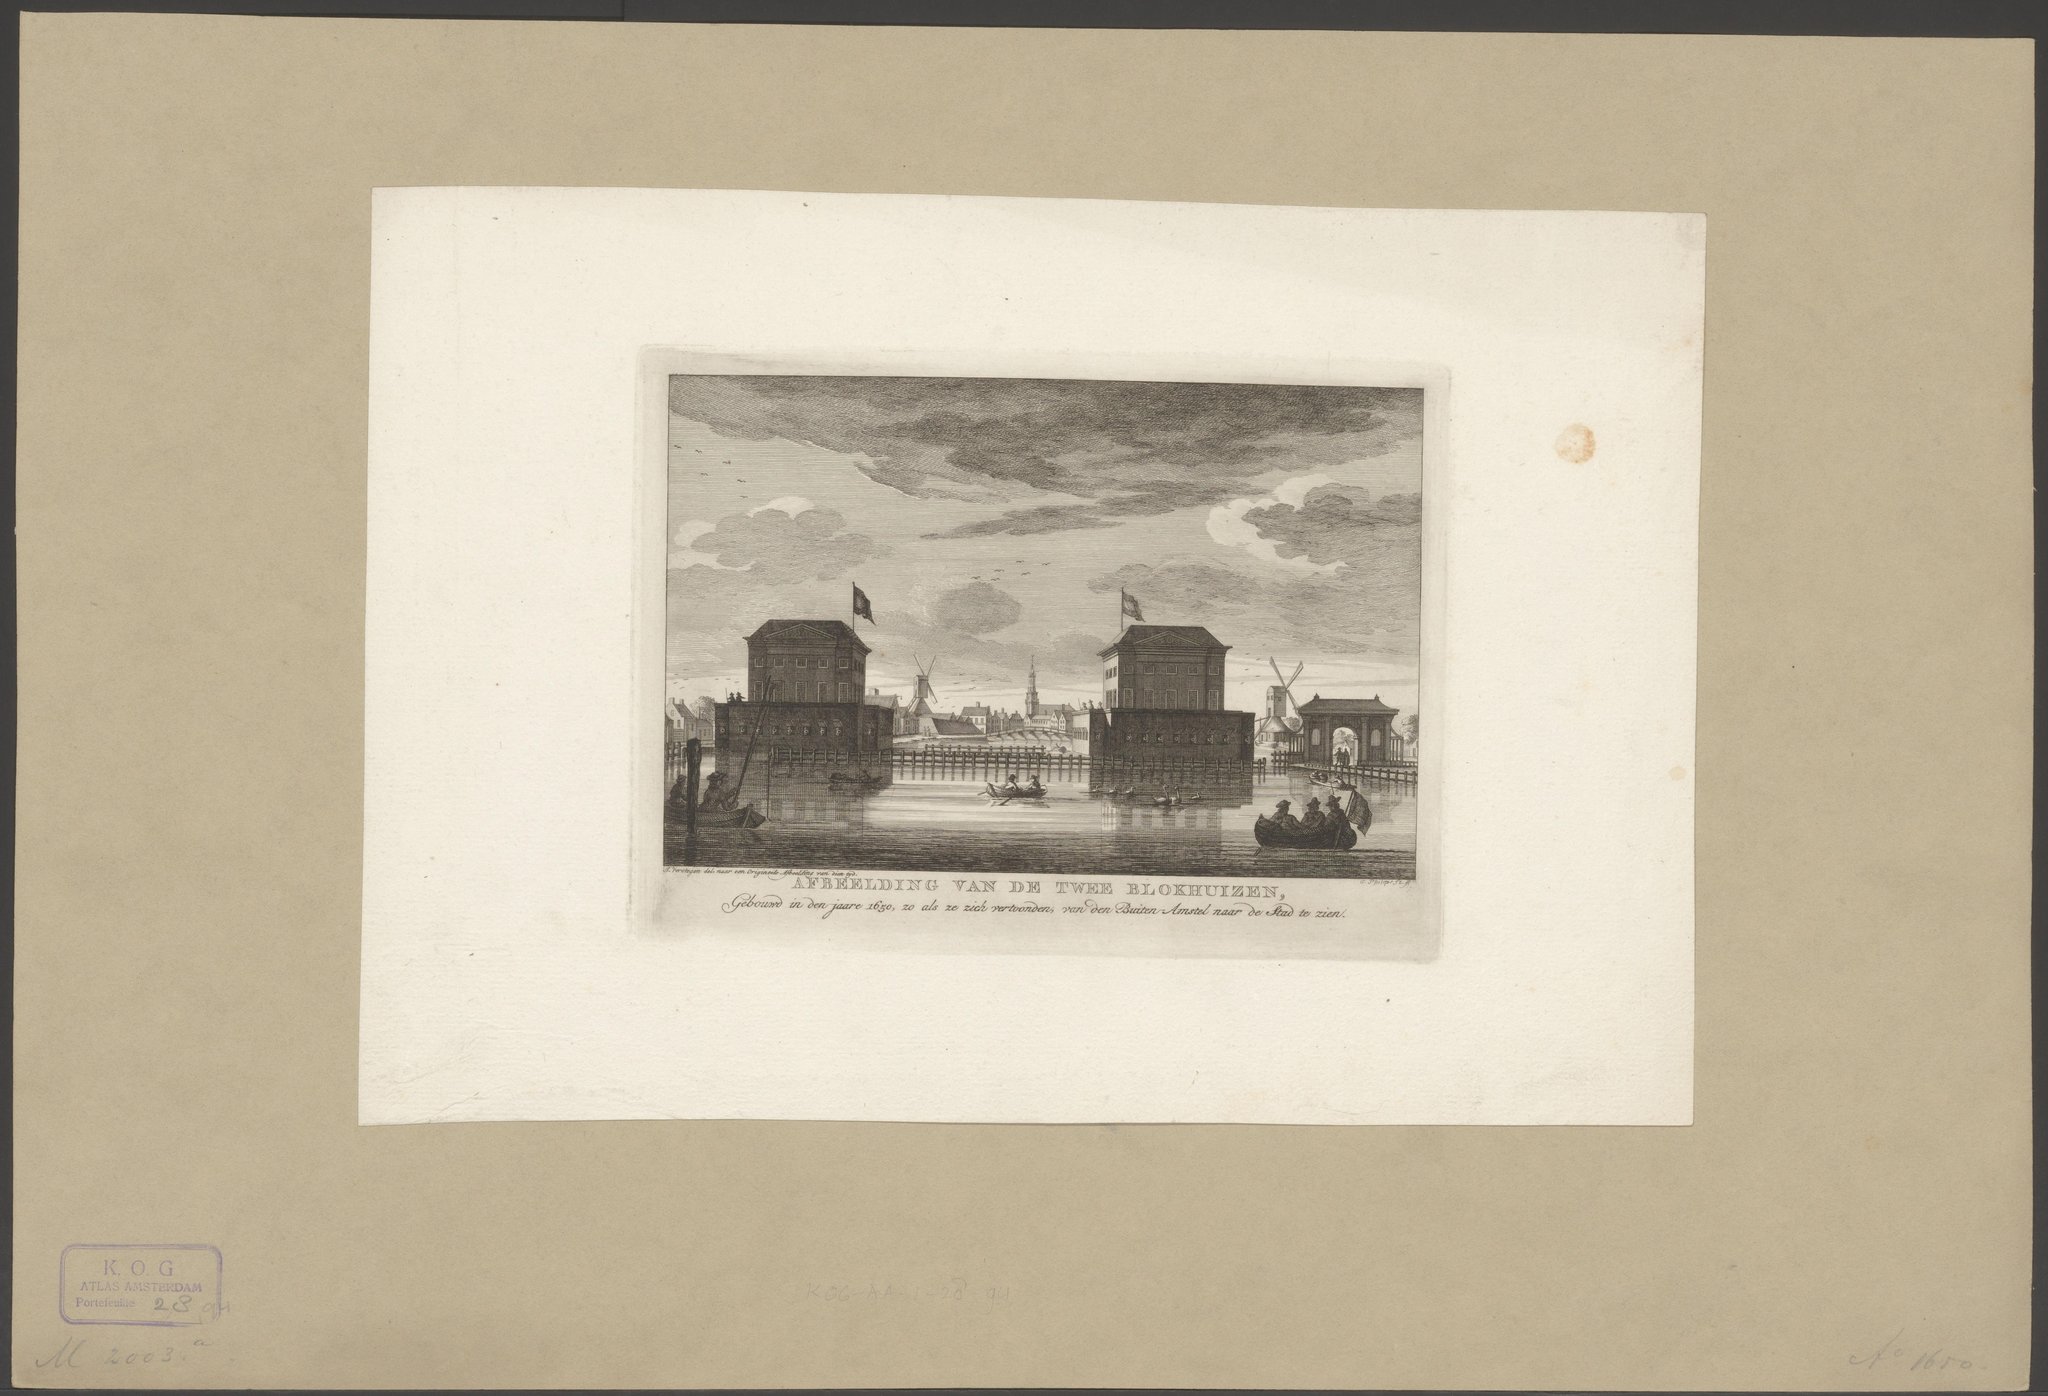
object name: print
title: Gezicht op de twee Blokhuizen in de Amstel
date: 1752-1789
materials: paper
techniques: engraving, etching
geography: amsterdam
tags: rowing-boat, canoe, etc., fortifications, military engineering, canals, waters (in city), windmill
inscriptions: collector's mark: Lugt 1641b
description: Gezicht op de twee Blokhuizen in de Amstel buiten Amsterdam, gebouwd ter verdediging van de stad na de mislukte aanslag door Willem II op Amsterdam op 30 juli 1650. Nadat ze in 1651 waren voltooid werden ze in juli 1654 alweer afgebroken. Onderwerpsrubriek binnen de Atlas Amsterdam: Vestingwerken: Bolwerken - Rondeel - Wachttorens - Blokhuizen - Kazematten - Ontwerpen Kostuum Alva.